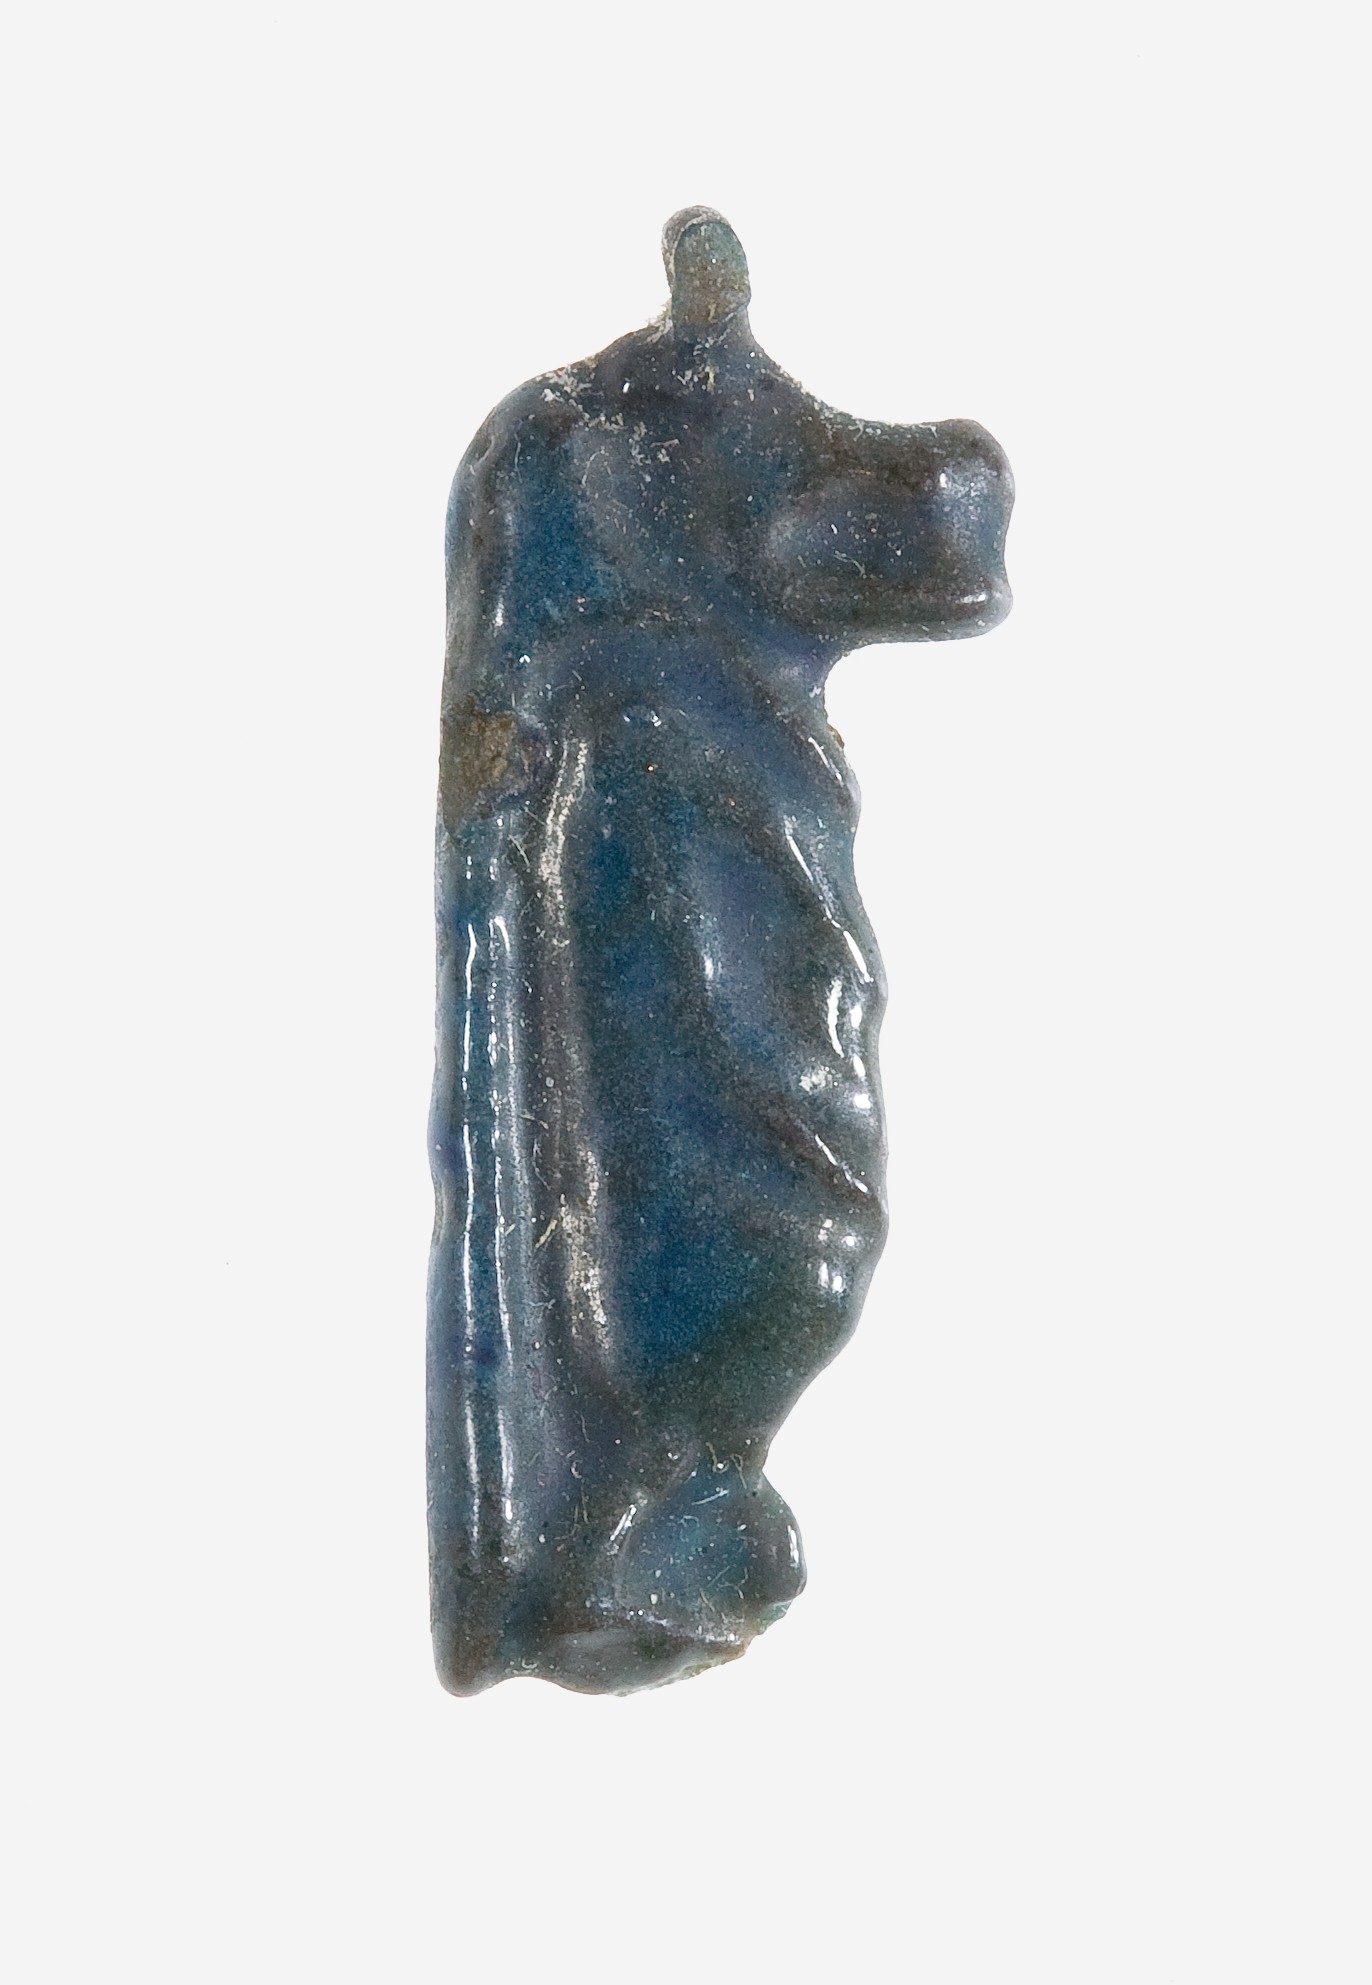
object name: amulet, taweret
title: Taweret Amulet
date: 1390-1352 BCE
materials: faience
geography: egypt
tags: taweret